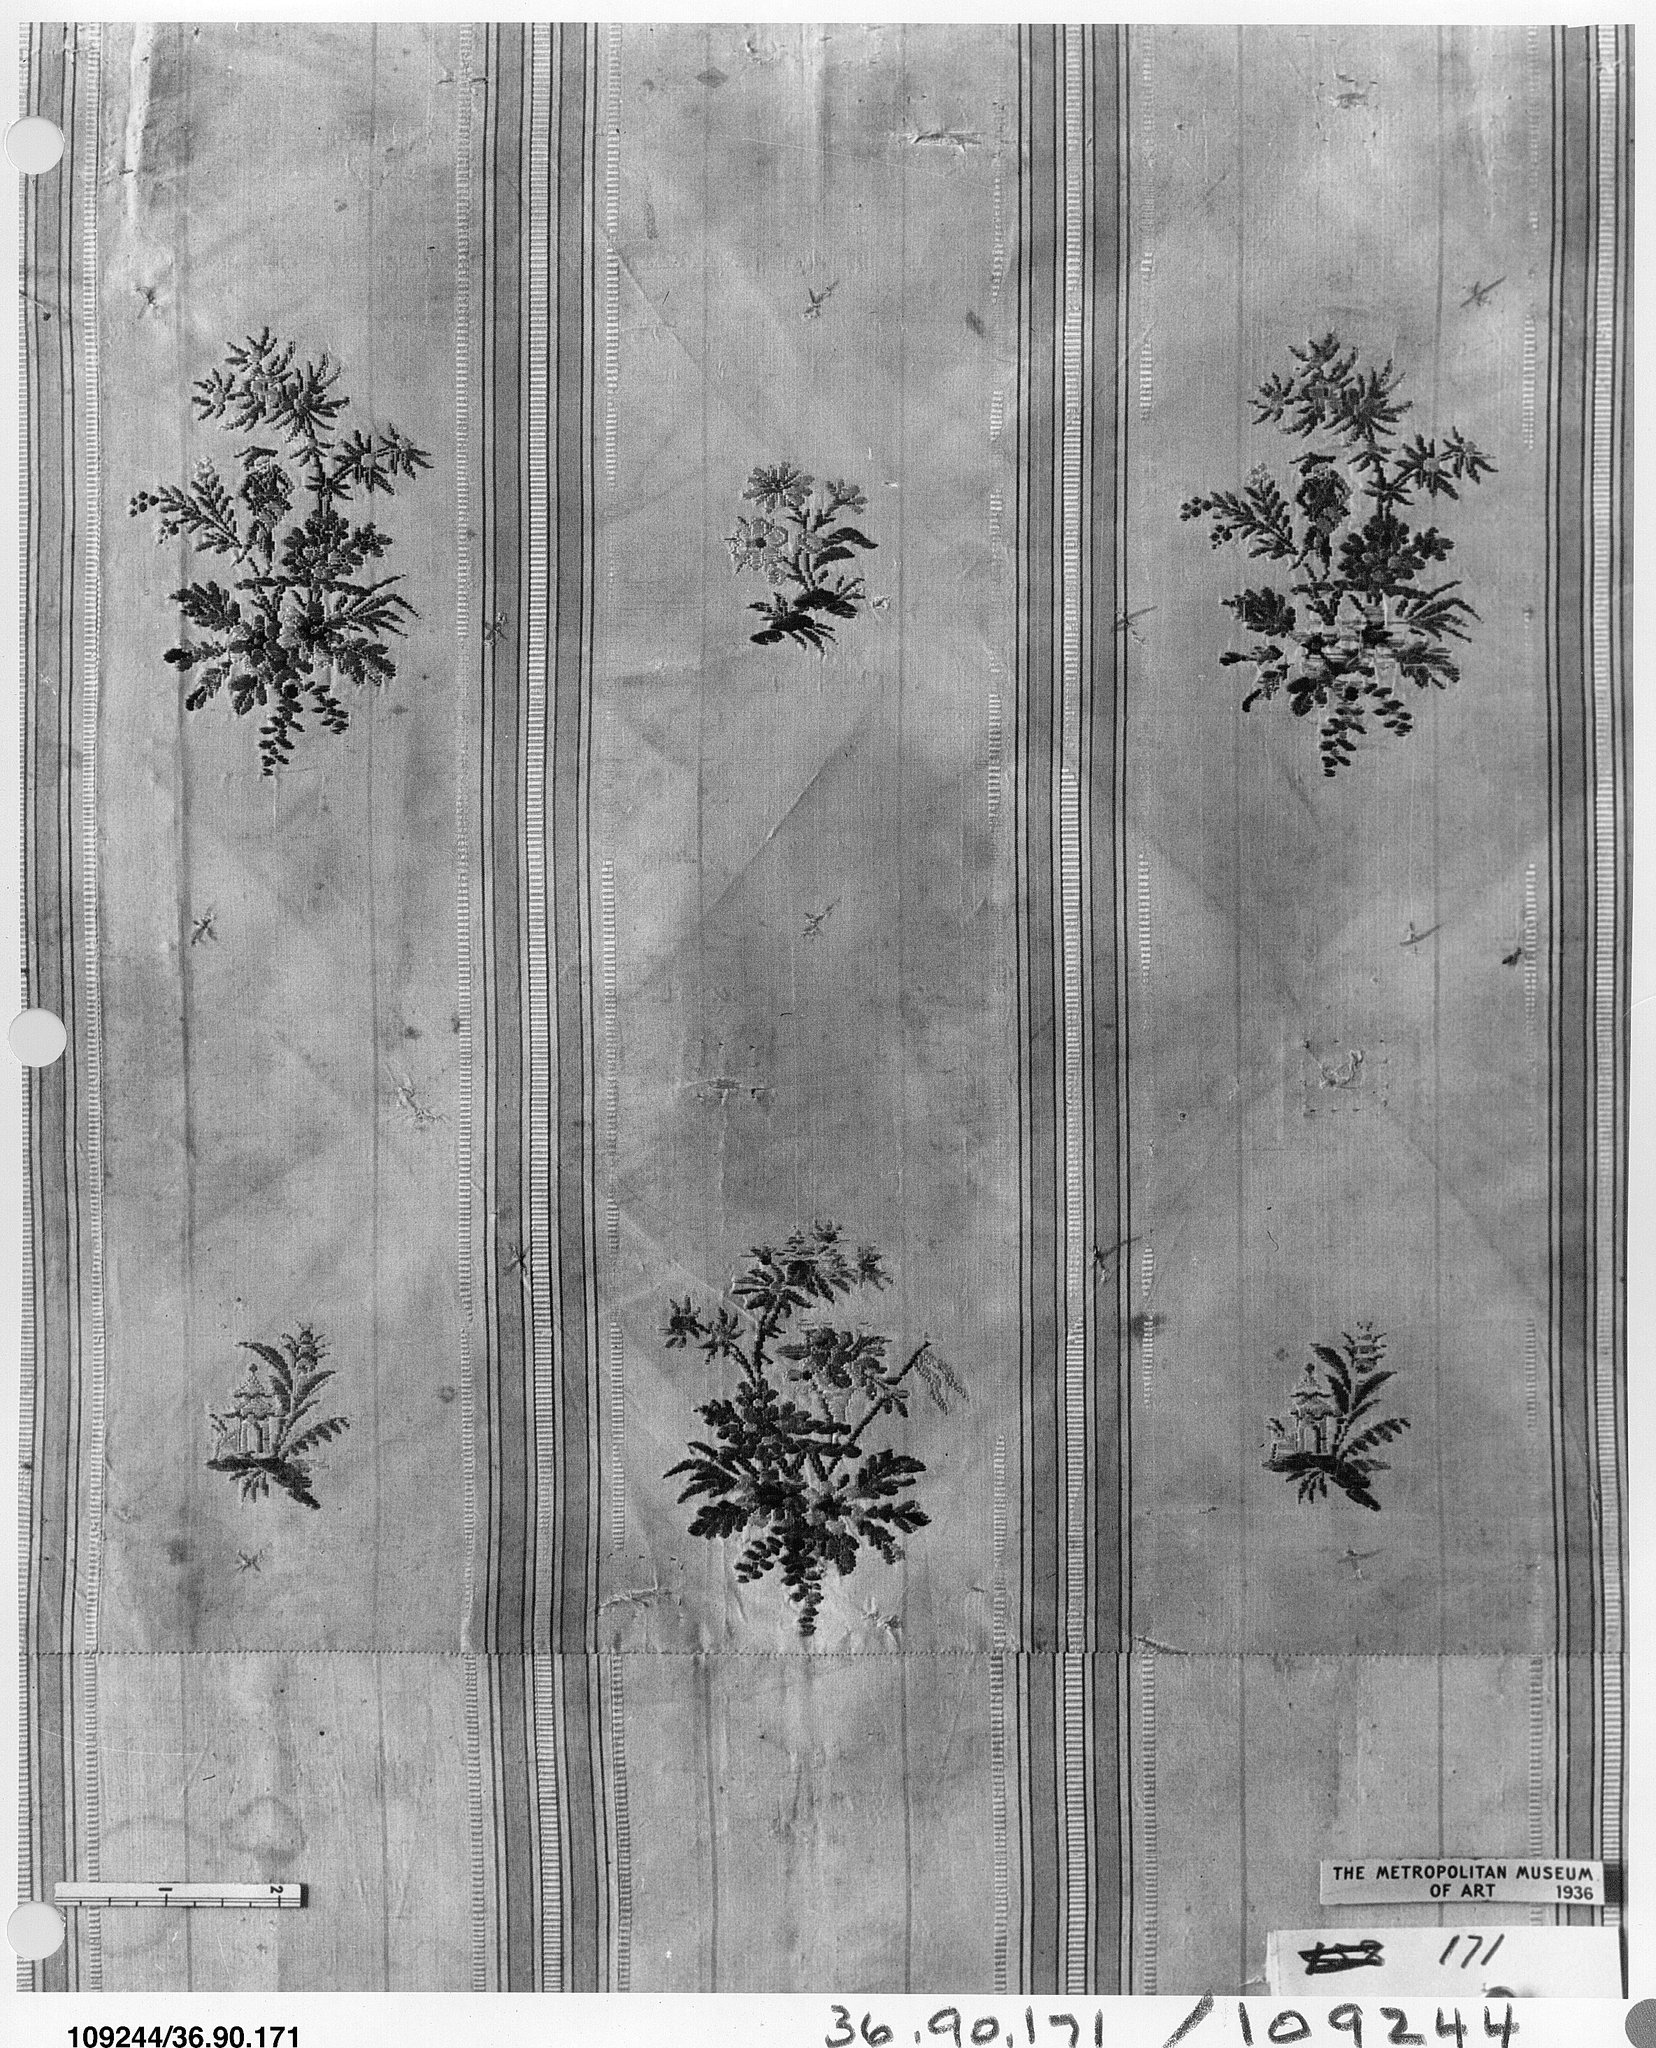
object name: piece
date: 1701-1800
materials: silk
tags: flowers